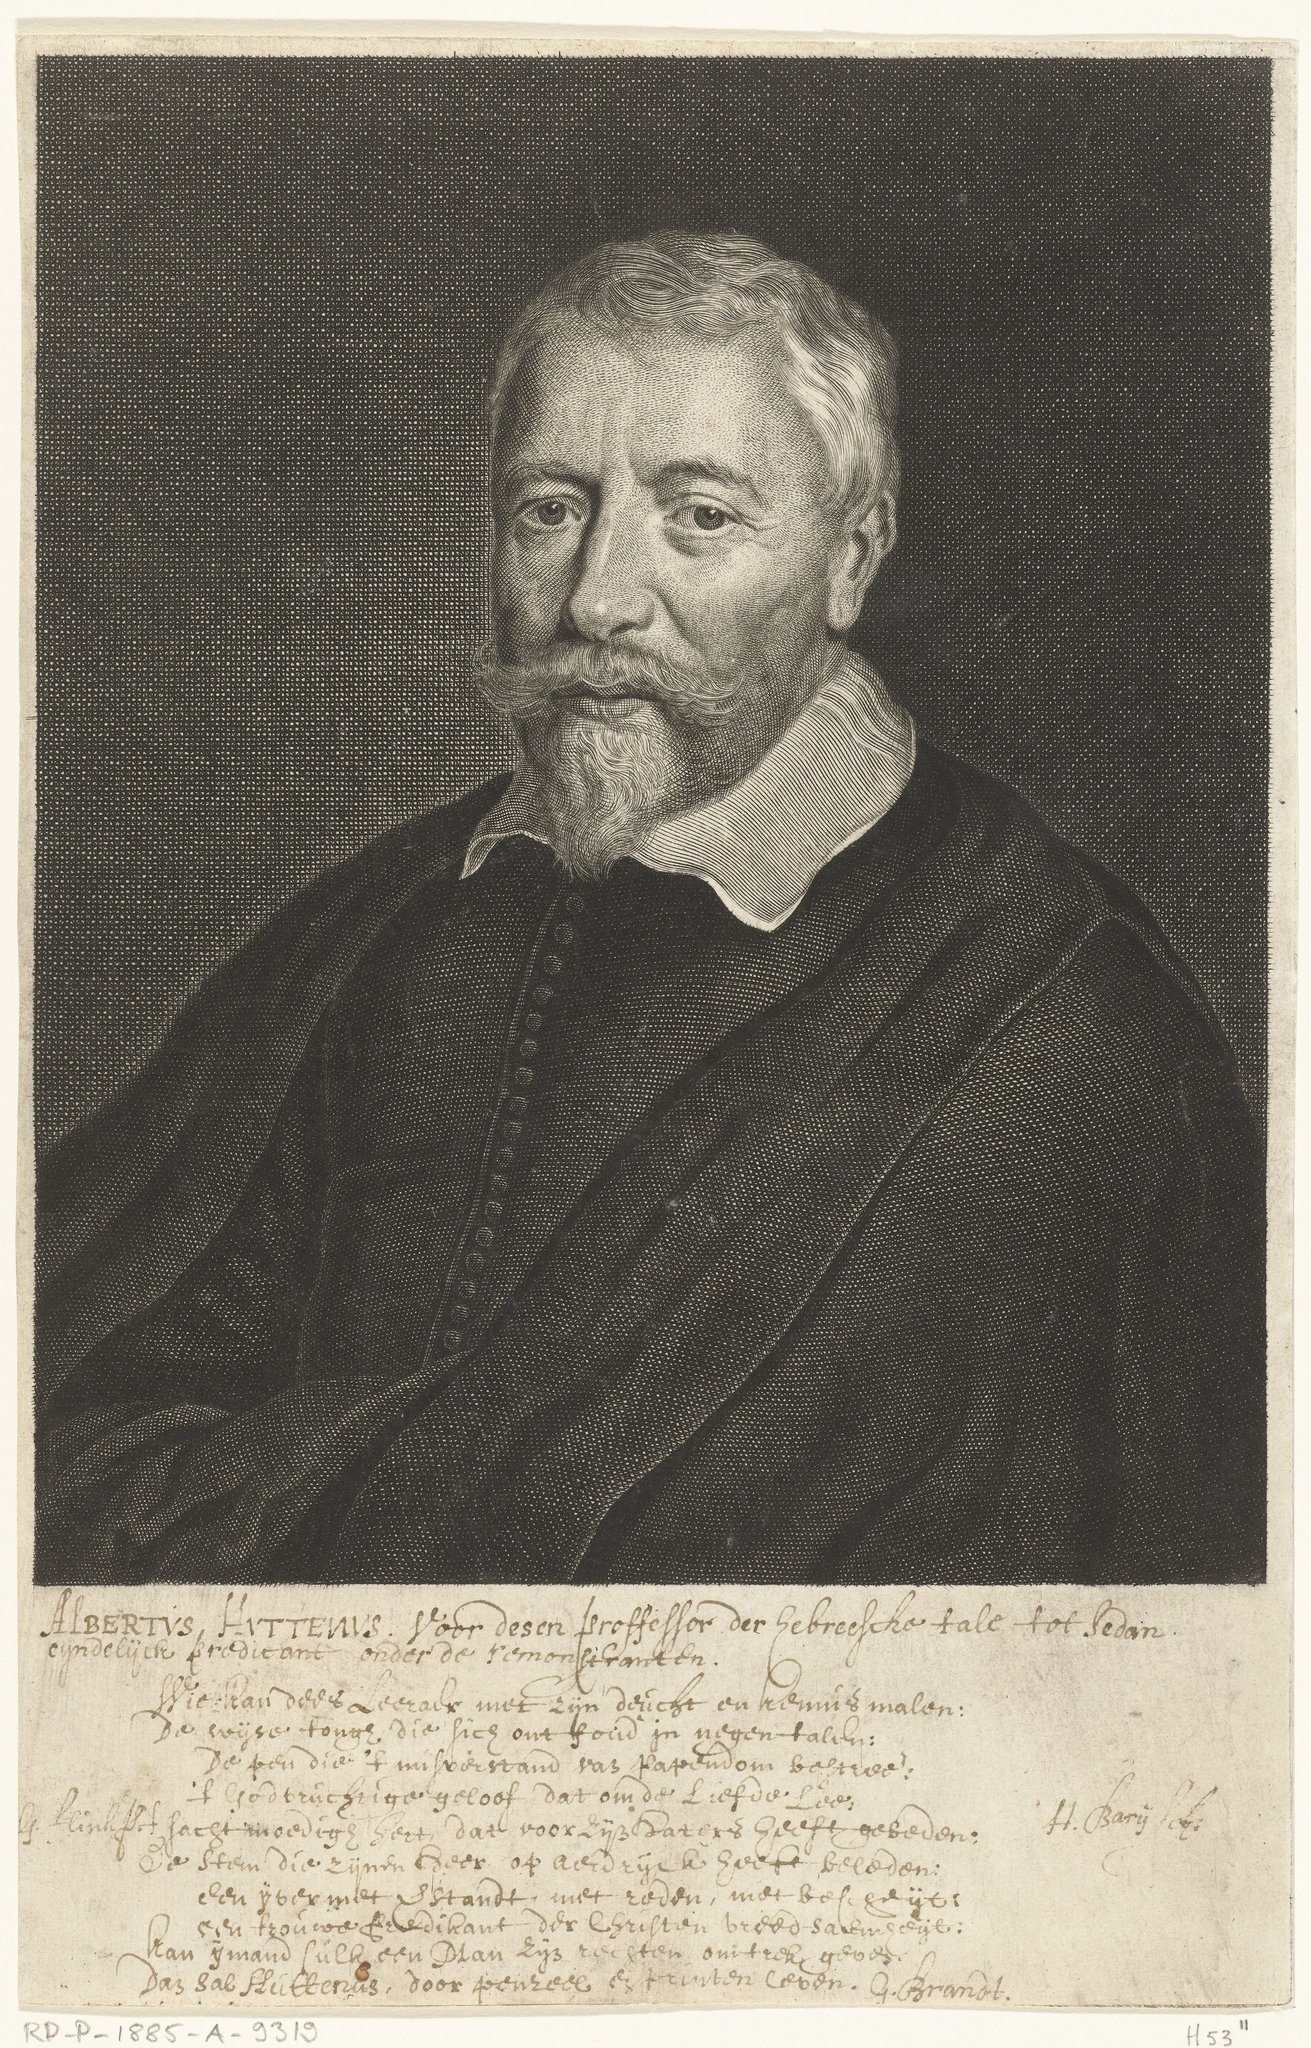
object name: print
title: Portret van Albertus Huttenus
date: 1657-1707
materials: paper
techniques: engraving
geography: netherlands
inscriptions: inscription: ‘Albertvs Hvttenvs. Voor desen professor der hebreesche tale tot Sedan [...] G. Brandt.’, collector's mark: Lugt 2228